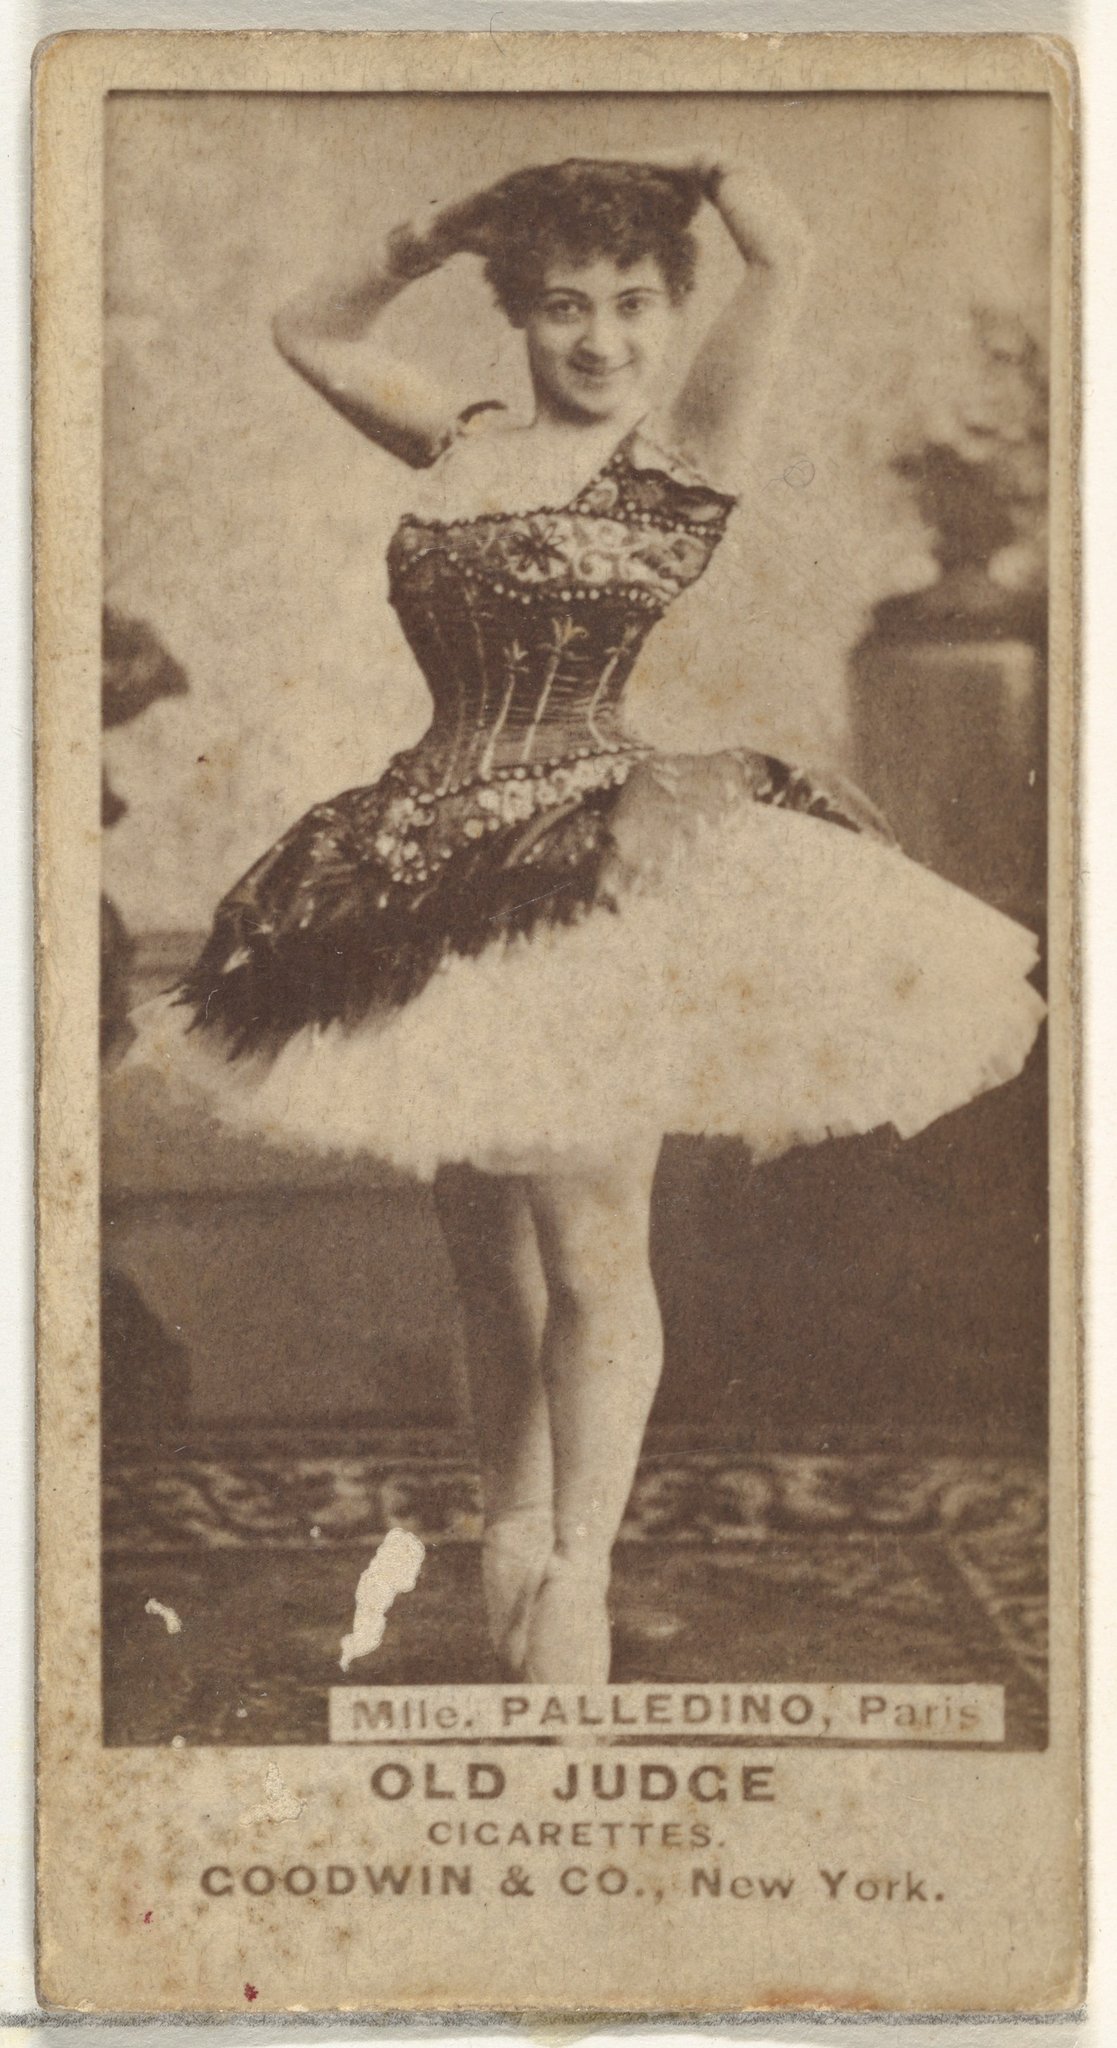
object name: photograph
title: Mlle. Palledino, Paris, from the Actors and Actresses series (N171) for Old Judge Cigarettes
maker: goodwin & company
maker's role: publisher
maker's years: 1850-1950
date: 1886-1890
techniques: albumen silver print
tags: portraits,women,actresses